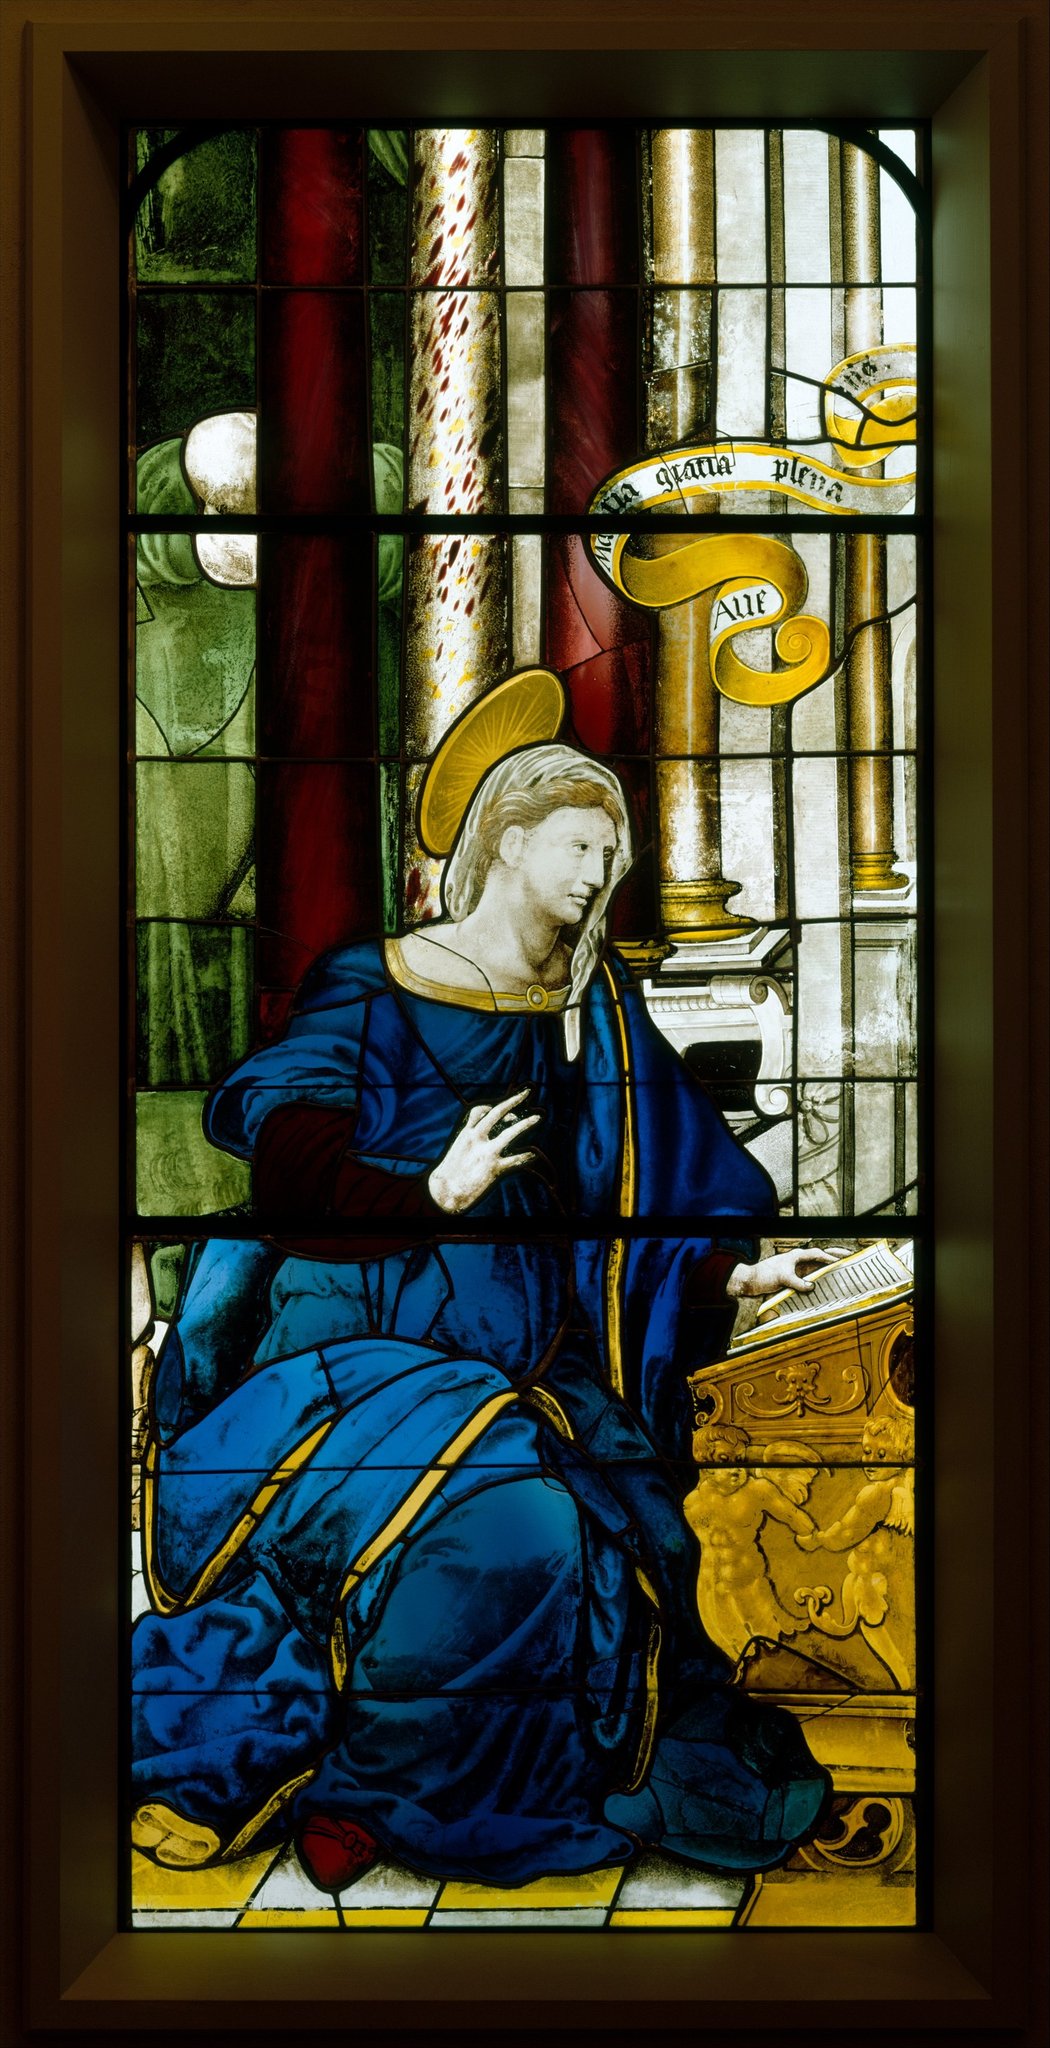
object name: panel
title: The Annunciate Virgin (one of a pair)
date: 1552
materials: glass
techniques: enamel, stain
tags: virgin mary,annunciation